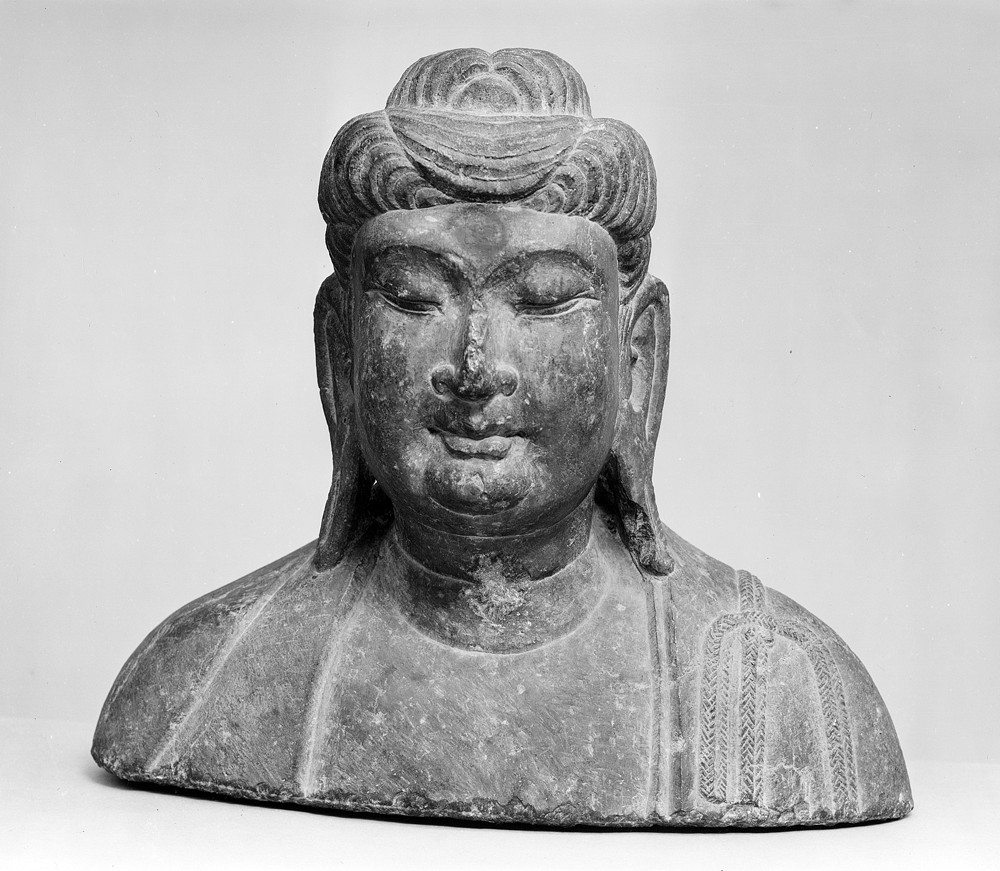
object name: bust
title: Buddha Head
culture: chinese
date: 1701-1800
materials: stone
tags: buddha